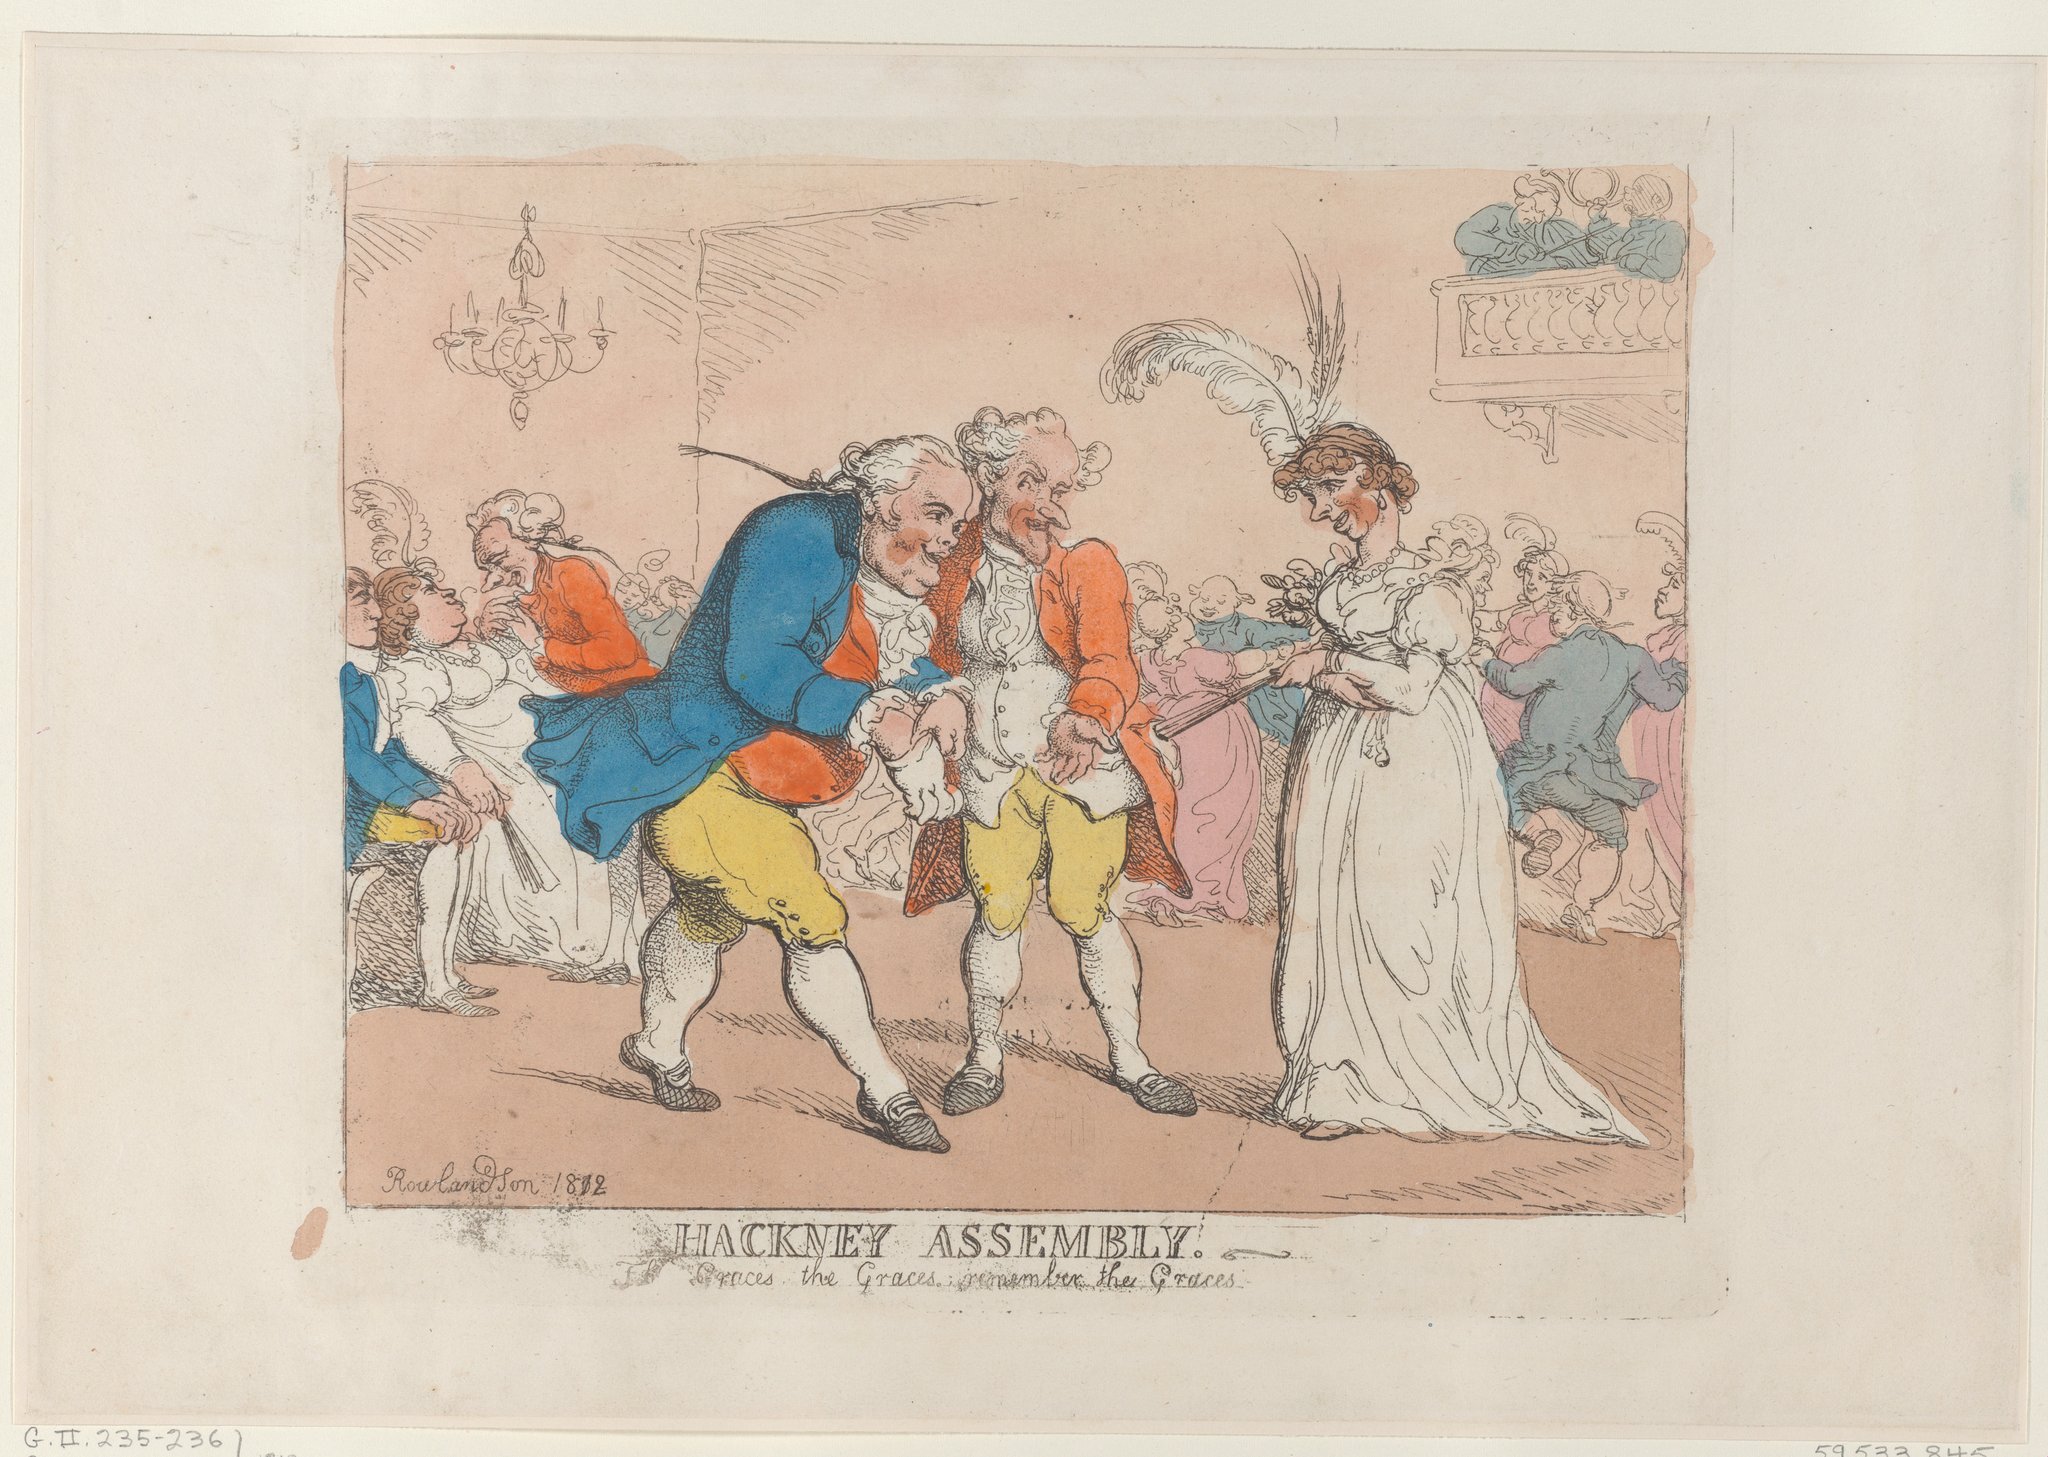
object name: print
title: Hackney Assembly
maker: thomas rowlandson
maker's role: artist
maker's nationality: british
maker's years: 1757-1827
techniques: etching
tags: satire,men,women